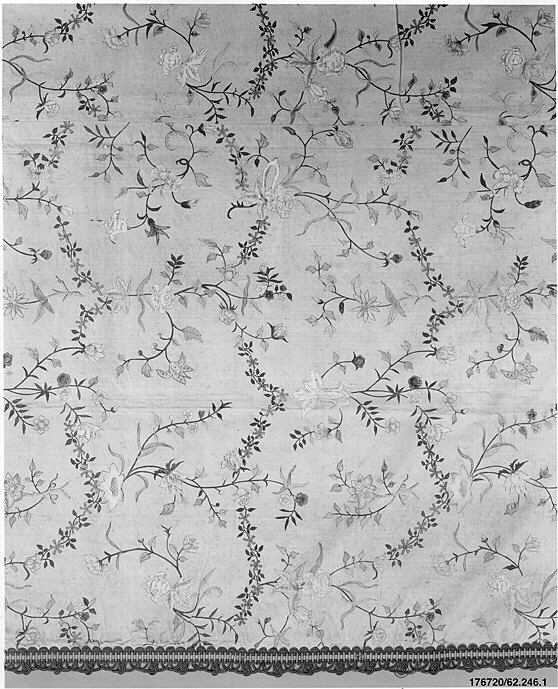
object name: curtain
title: Pair of curtains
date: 1701-1800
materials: cotton, paint, silk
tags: flowers